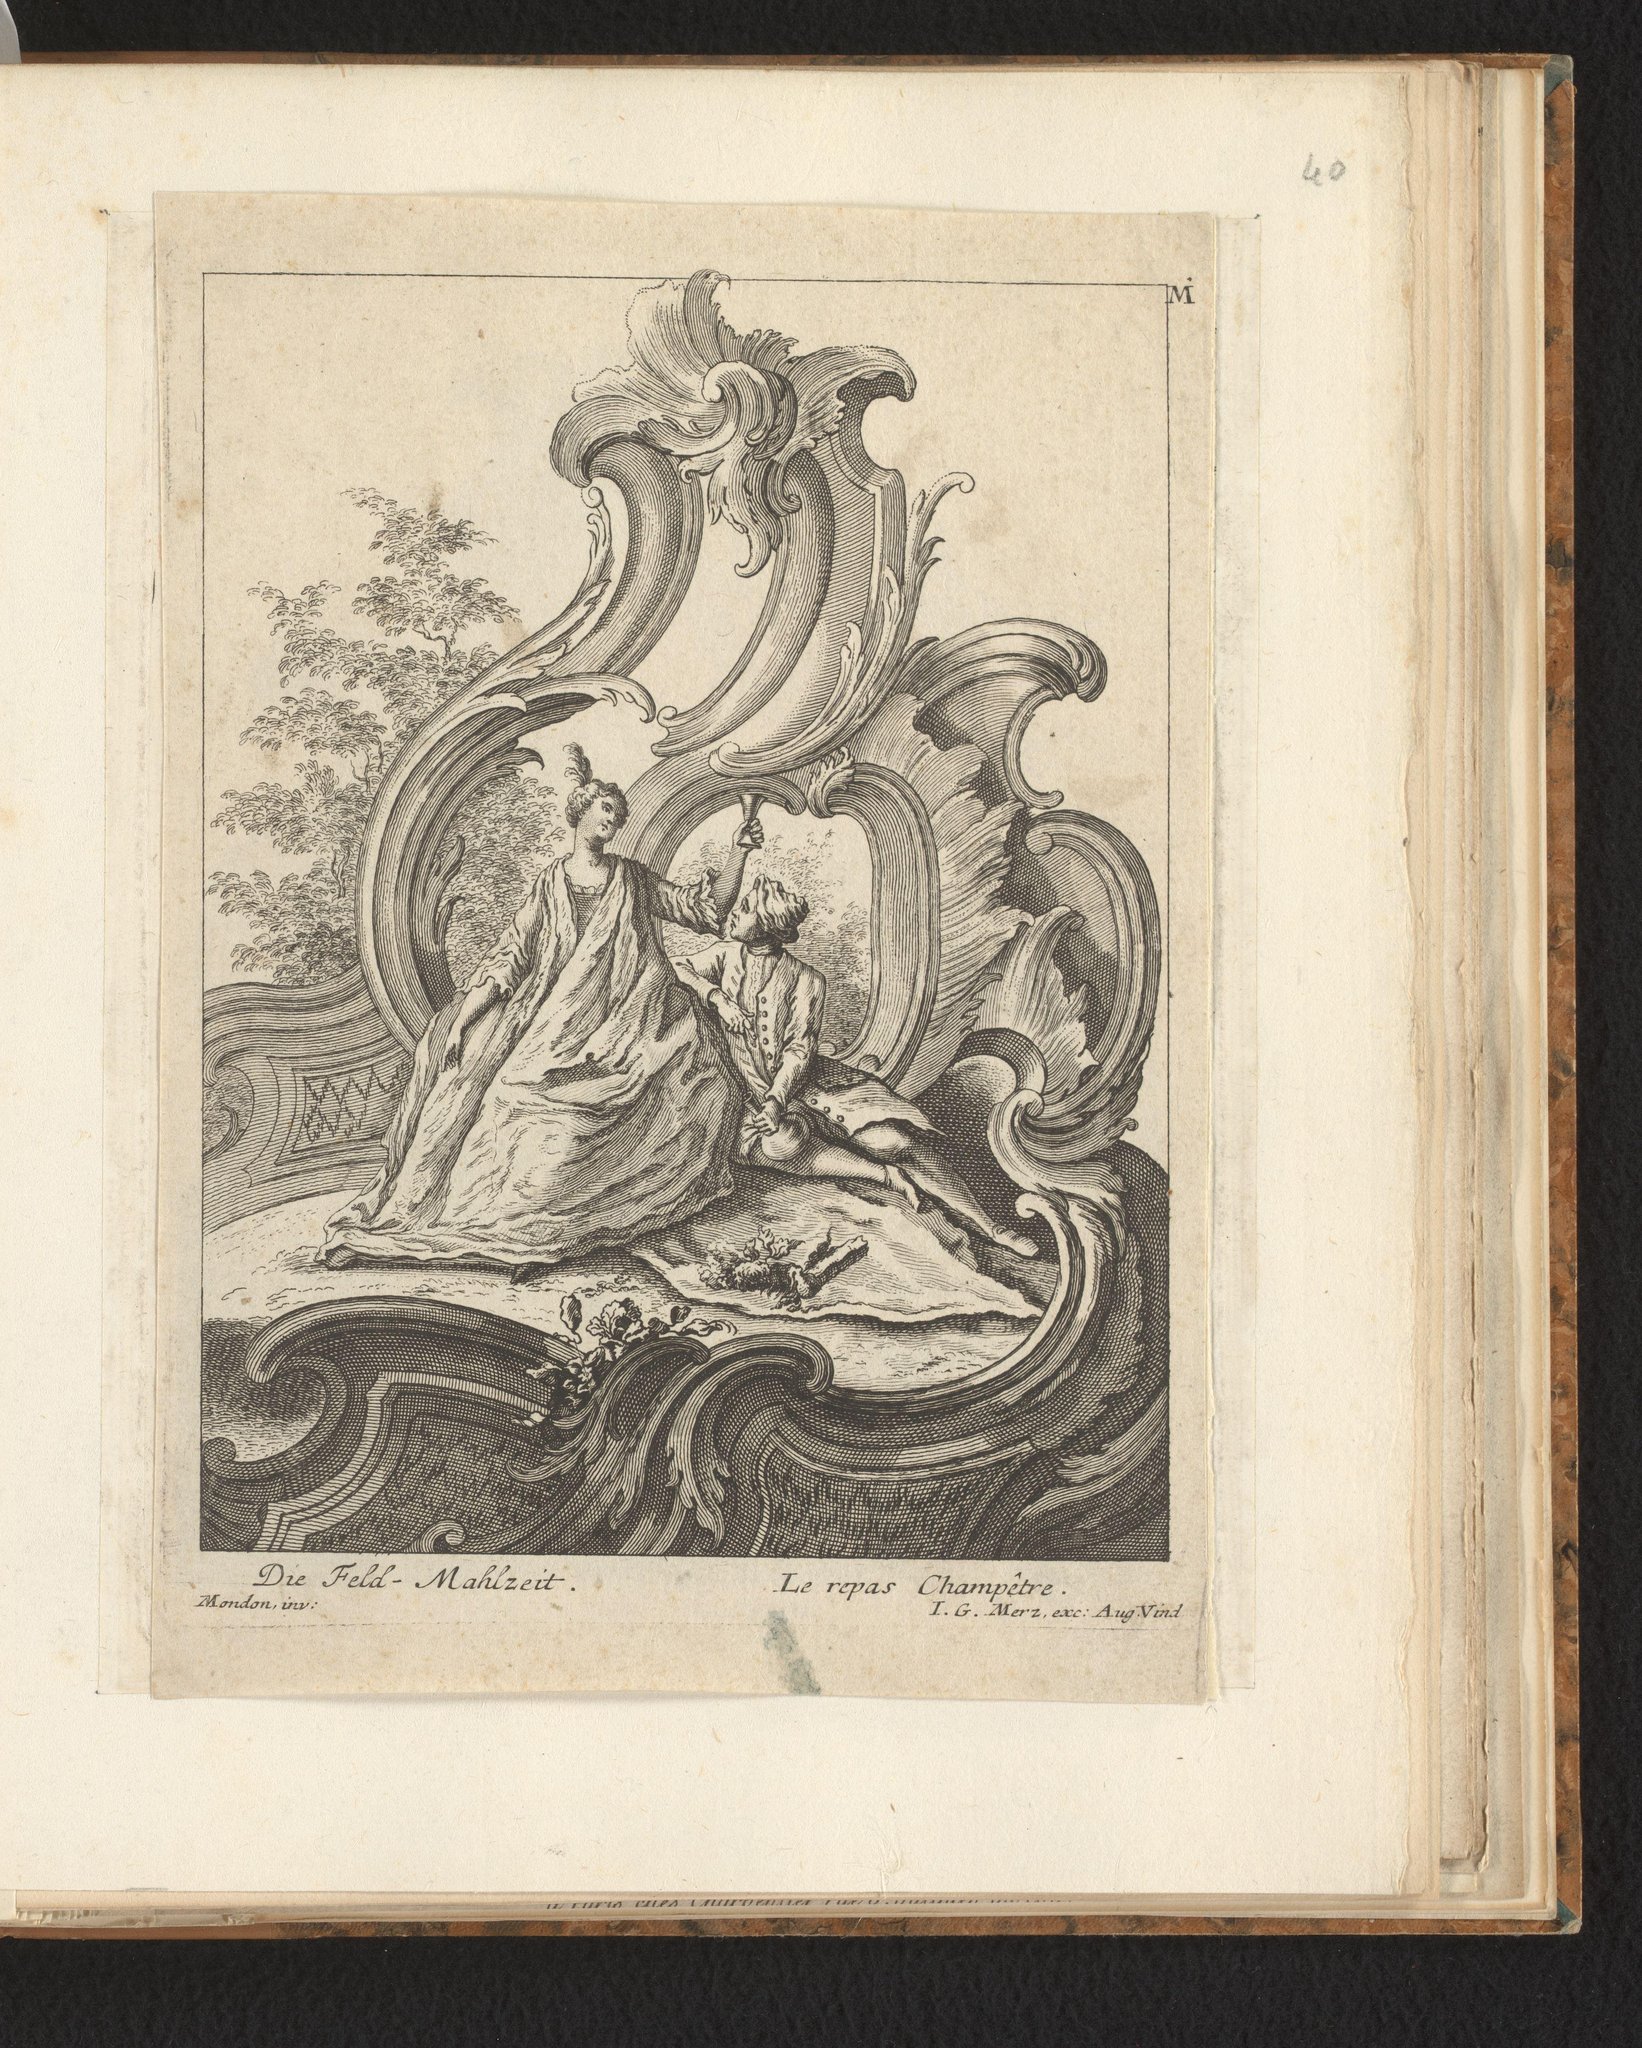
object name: print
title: Rocaille met drinkend paar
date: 1736-1762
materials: paper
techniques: etching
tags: rocaille ornament, making music; musician with instrument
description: Prent ligt los in het album, na de pagina met objectnummer RP-P-2002-269 waarvan de prent een gespiegelde kopie is.